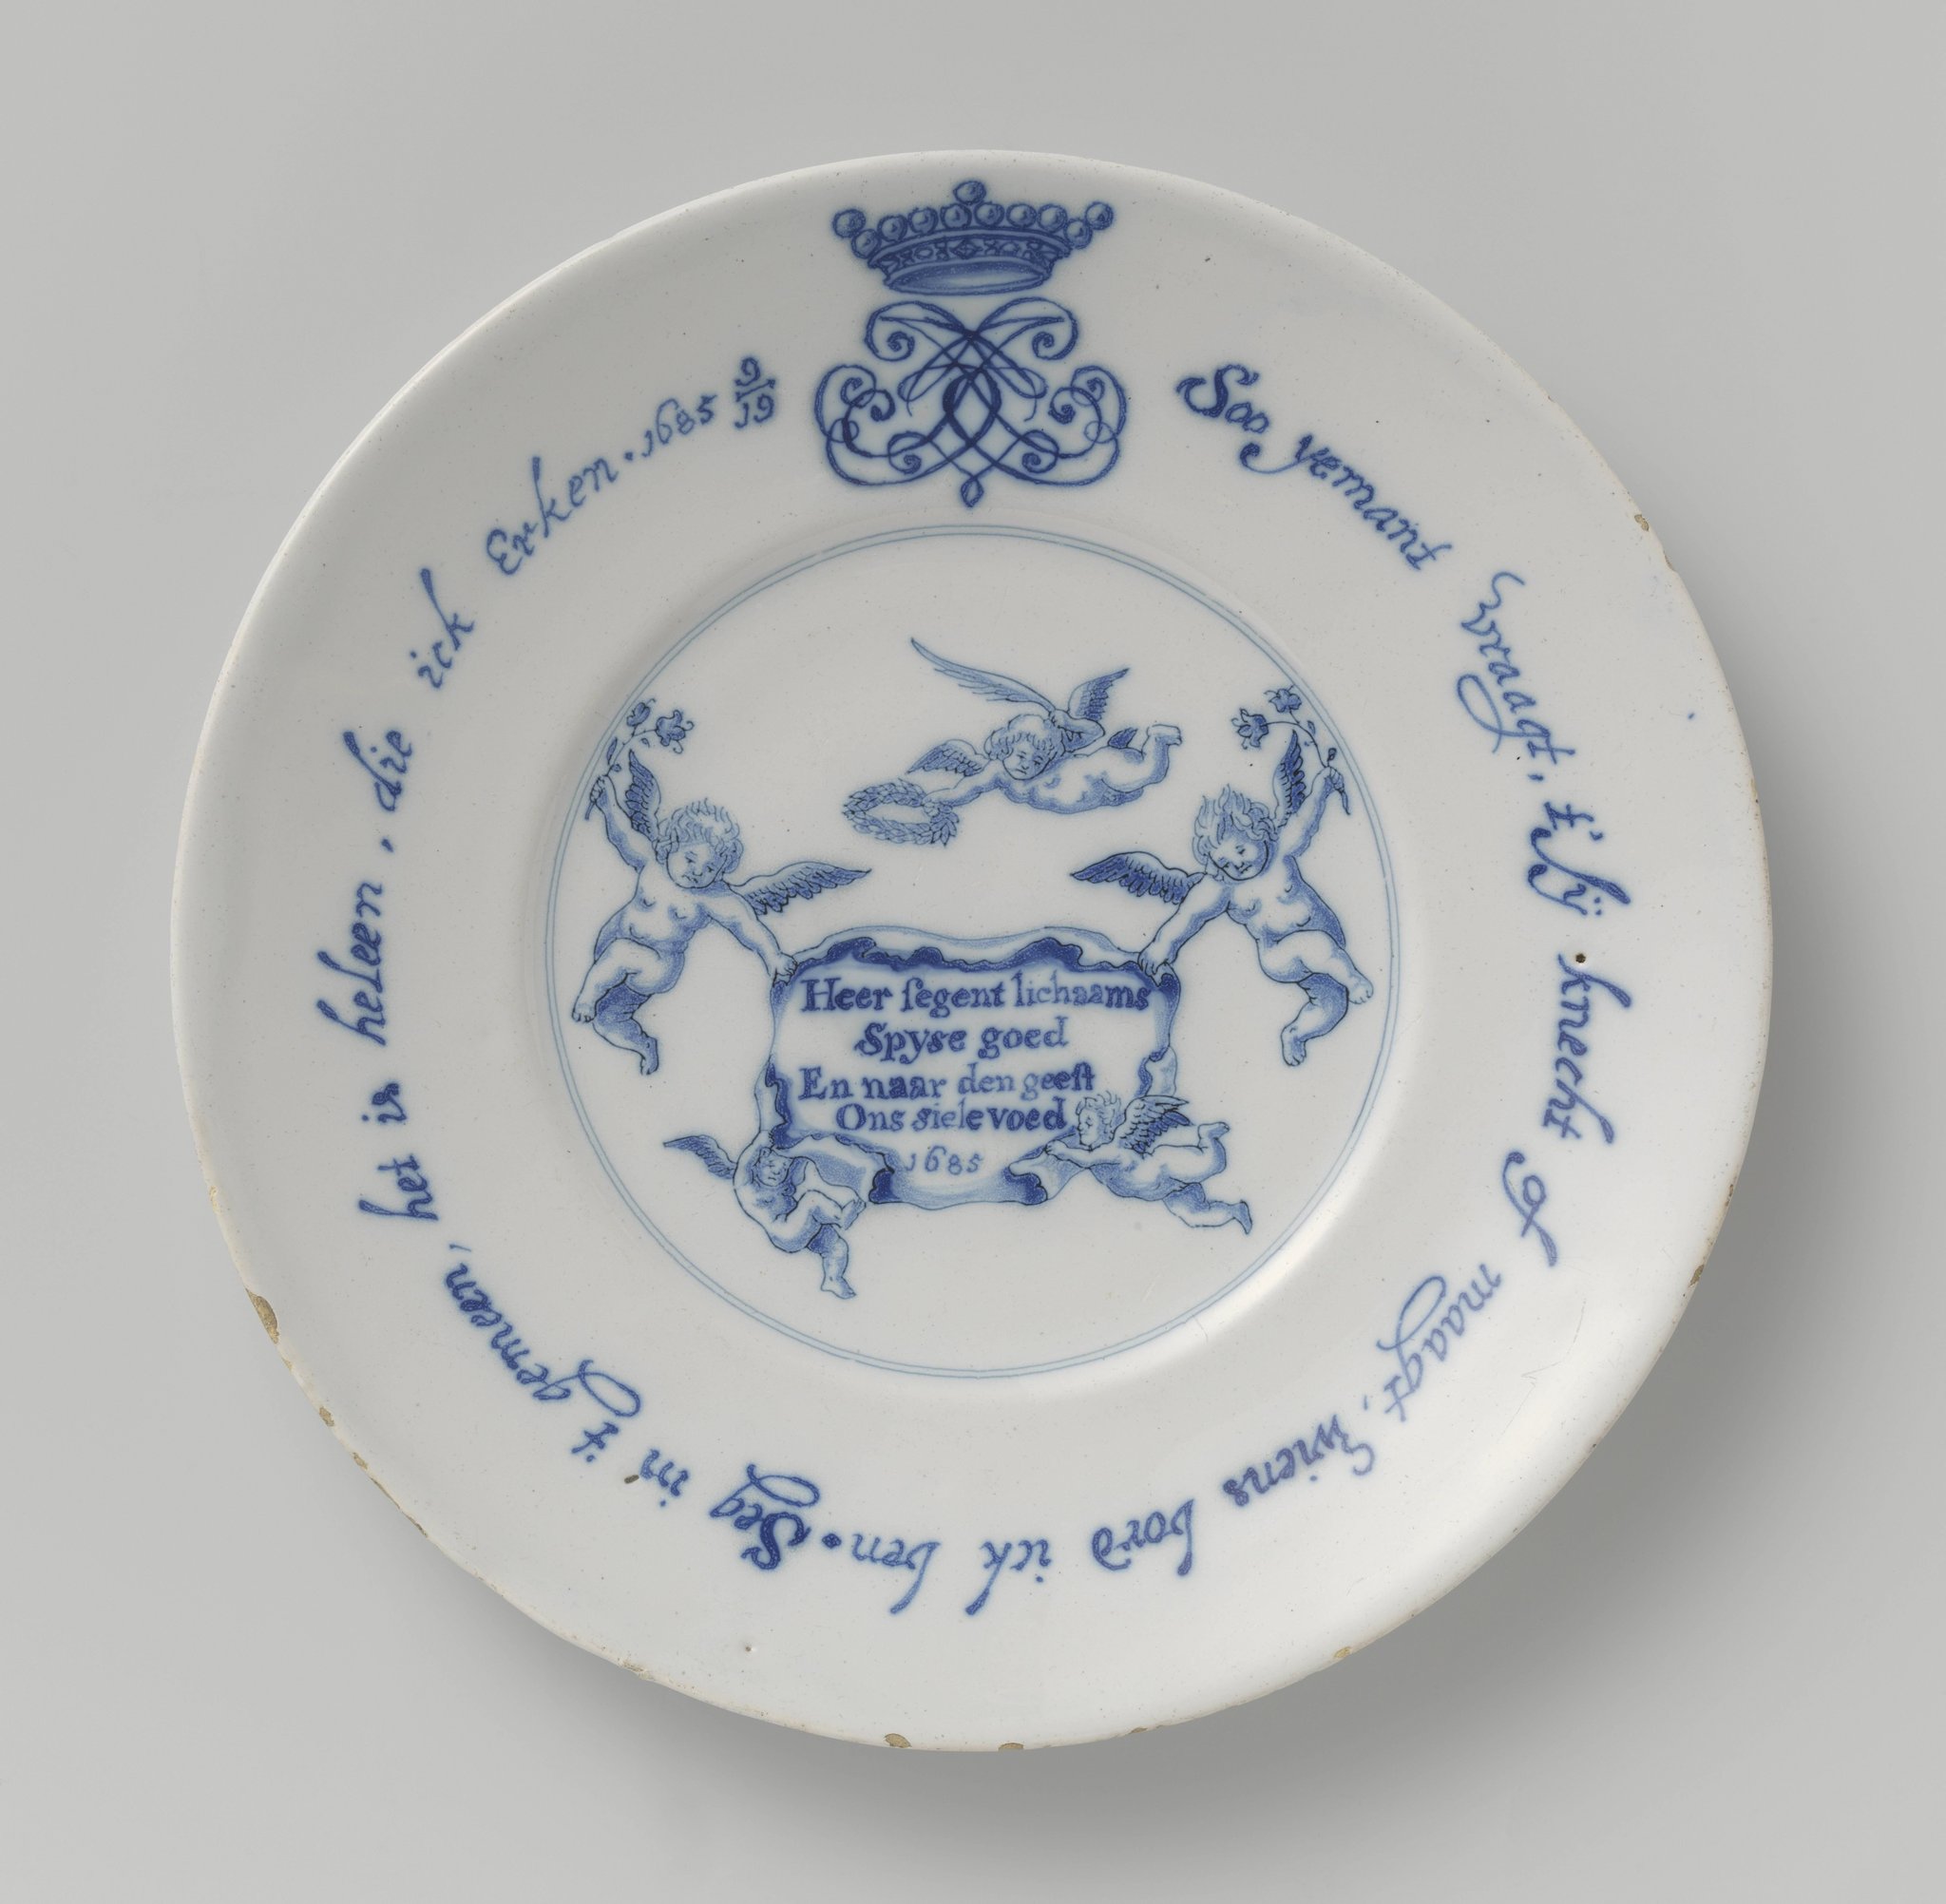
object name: plate dish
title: Bord van faience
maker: Anonymous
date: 1685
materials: faience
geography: delft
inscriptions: inscription: ‘Heer segent lichaams/ Spyse goed/ En naar den geeft/ ons siele voed/ 1685’, collector's mark: ‘J. F. Loudon’, seal: ‘158’, inscription: ‘Soo yemant vraagt, 't sij knecht of maagt, wiens bord ick ben. Seg in 't gemeen, het is heleen, die ick Erken. 1685 9/19’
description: Bord van faïence met een monogram en tekst, vermoedelijk gemaakt ter gelegenheid van een huwelijk.